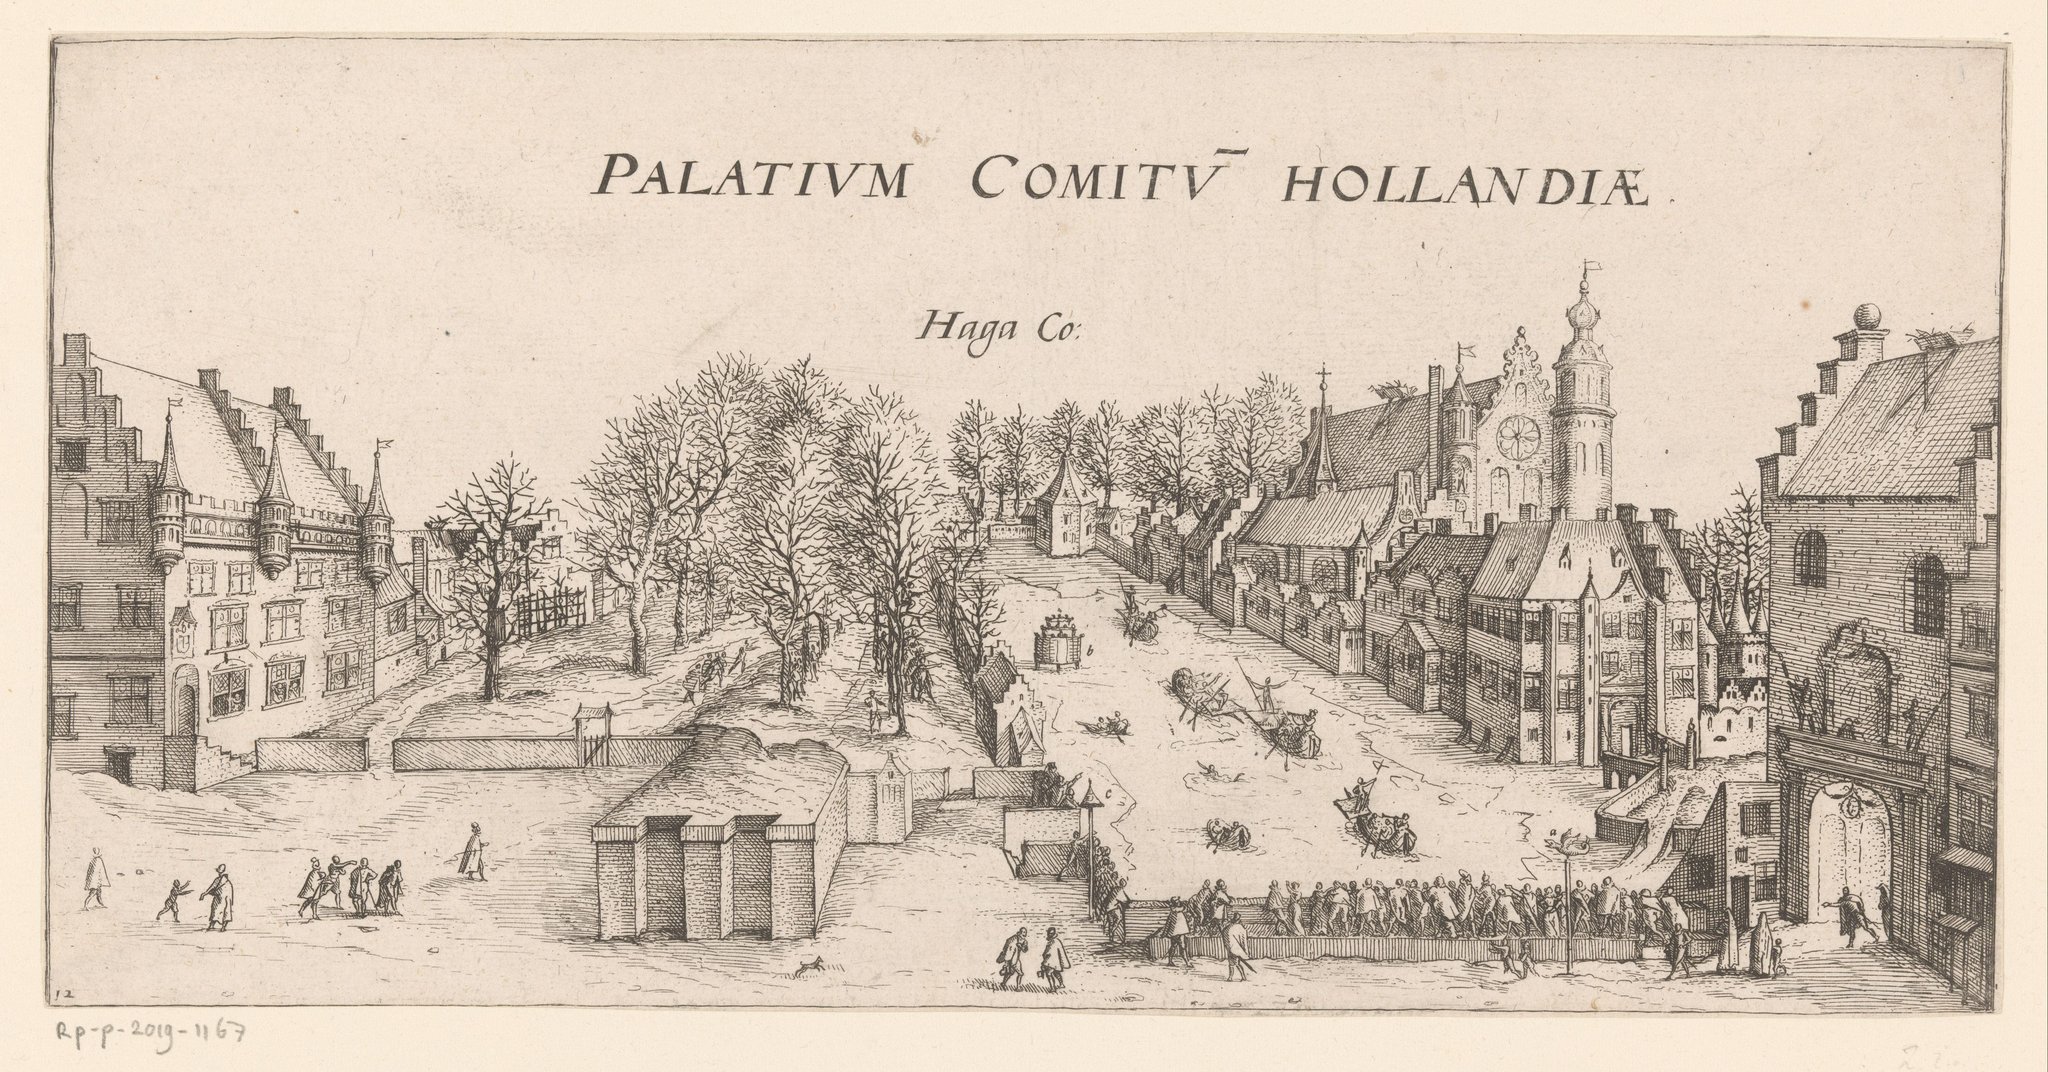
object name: print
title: Gezicht op het Buitenhof te Den Haag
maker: jacob savery (i)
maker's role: draughtsman, painter, print maker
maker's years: 1566-1603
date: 1586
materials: paper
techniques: etching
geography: northern netherlands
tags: robert dudley (1st earl of leicester), triumphal entry and public reception, pageant, 'entrée solennelle', 'joyeuse entrée'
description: Prent is onderdeel van een plaat met de feestelijke intocht gehouden door Robert Dudley, graaf van Leicester, te 's-Gravenhage op 6 januari 1586. Twaalf genummerde bladen bedoeld om achterelkaar tot een lange strook te monteren. De stoet met triomfpoorten, bogen, stellages met muzikanten en tonelen en vreugdevuren is afgebeeld in de eerste tien platen, de laatste twee platen zijn van het vuurwerk op het strand (te Scheveningen?) en van de Hofvijver en het Binnenhof. Voor het geheel zie: RP-P-OB-80.445.